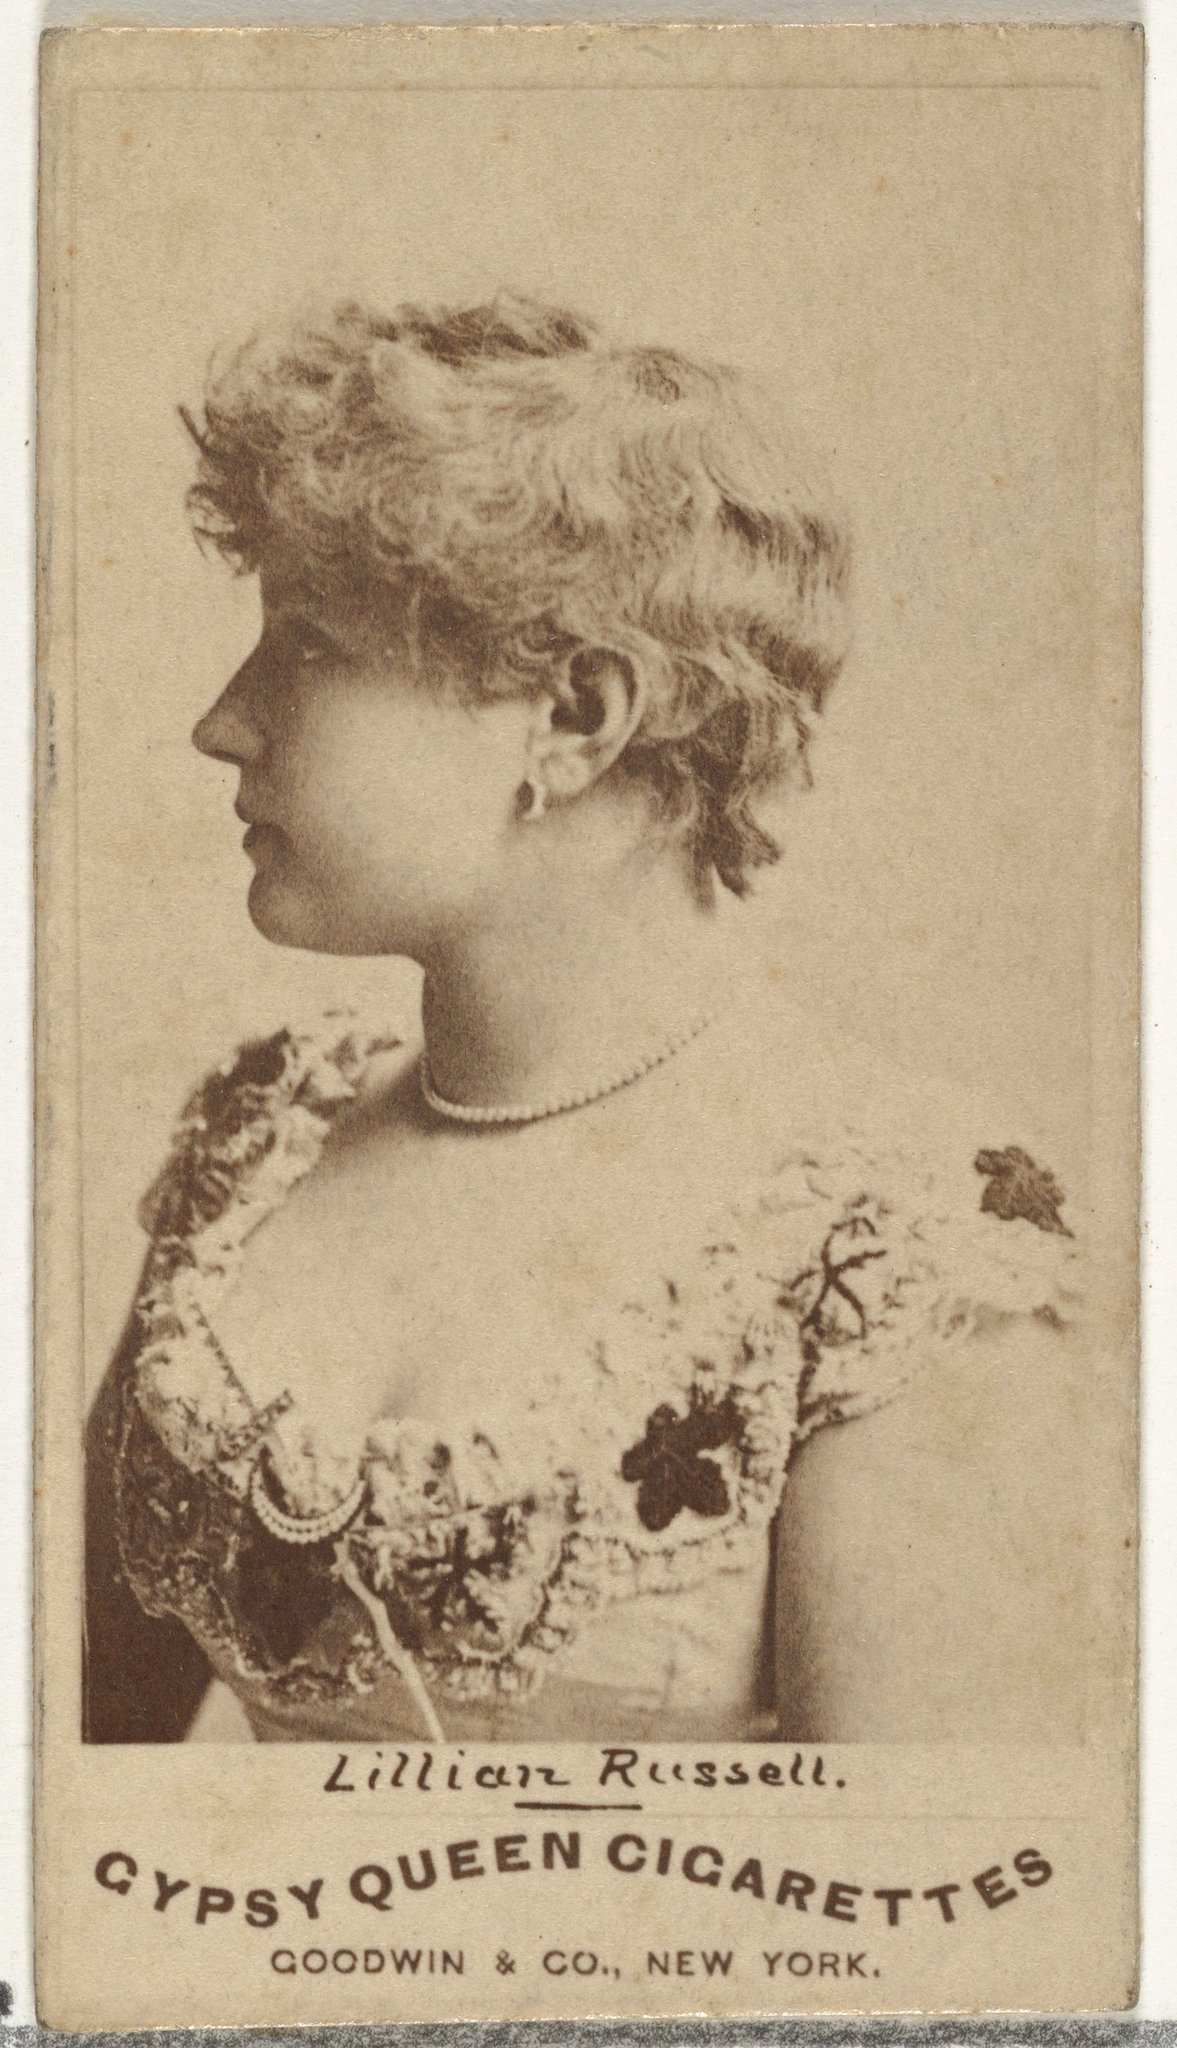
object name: photograph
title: Lillian Russell, from the Actors and Actresses series (N171) for Gypsy Queen Cigarettes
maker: goodwin & company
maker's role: publisher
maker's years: 1850-1950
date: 1886-1890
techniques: albumen silver print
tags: portraits,women,actresses